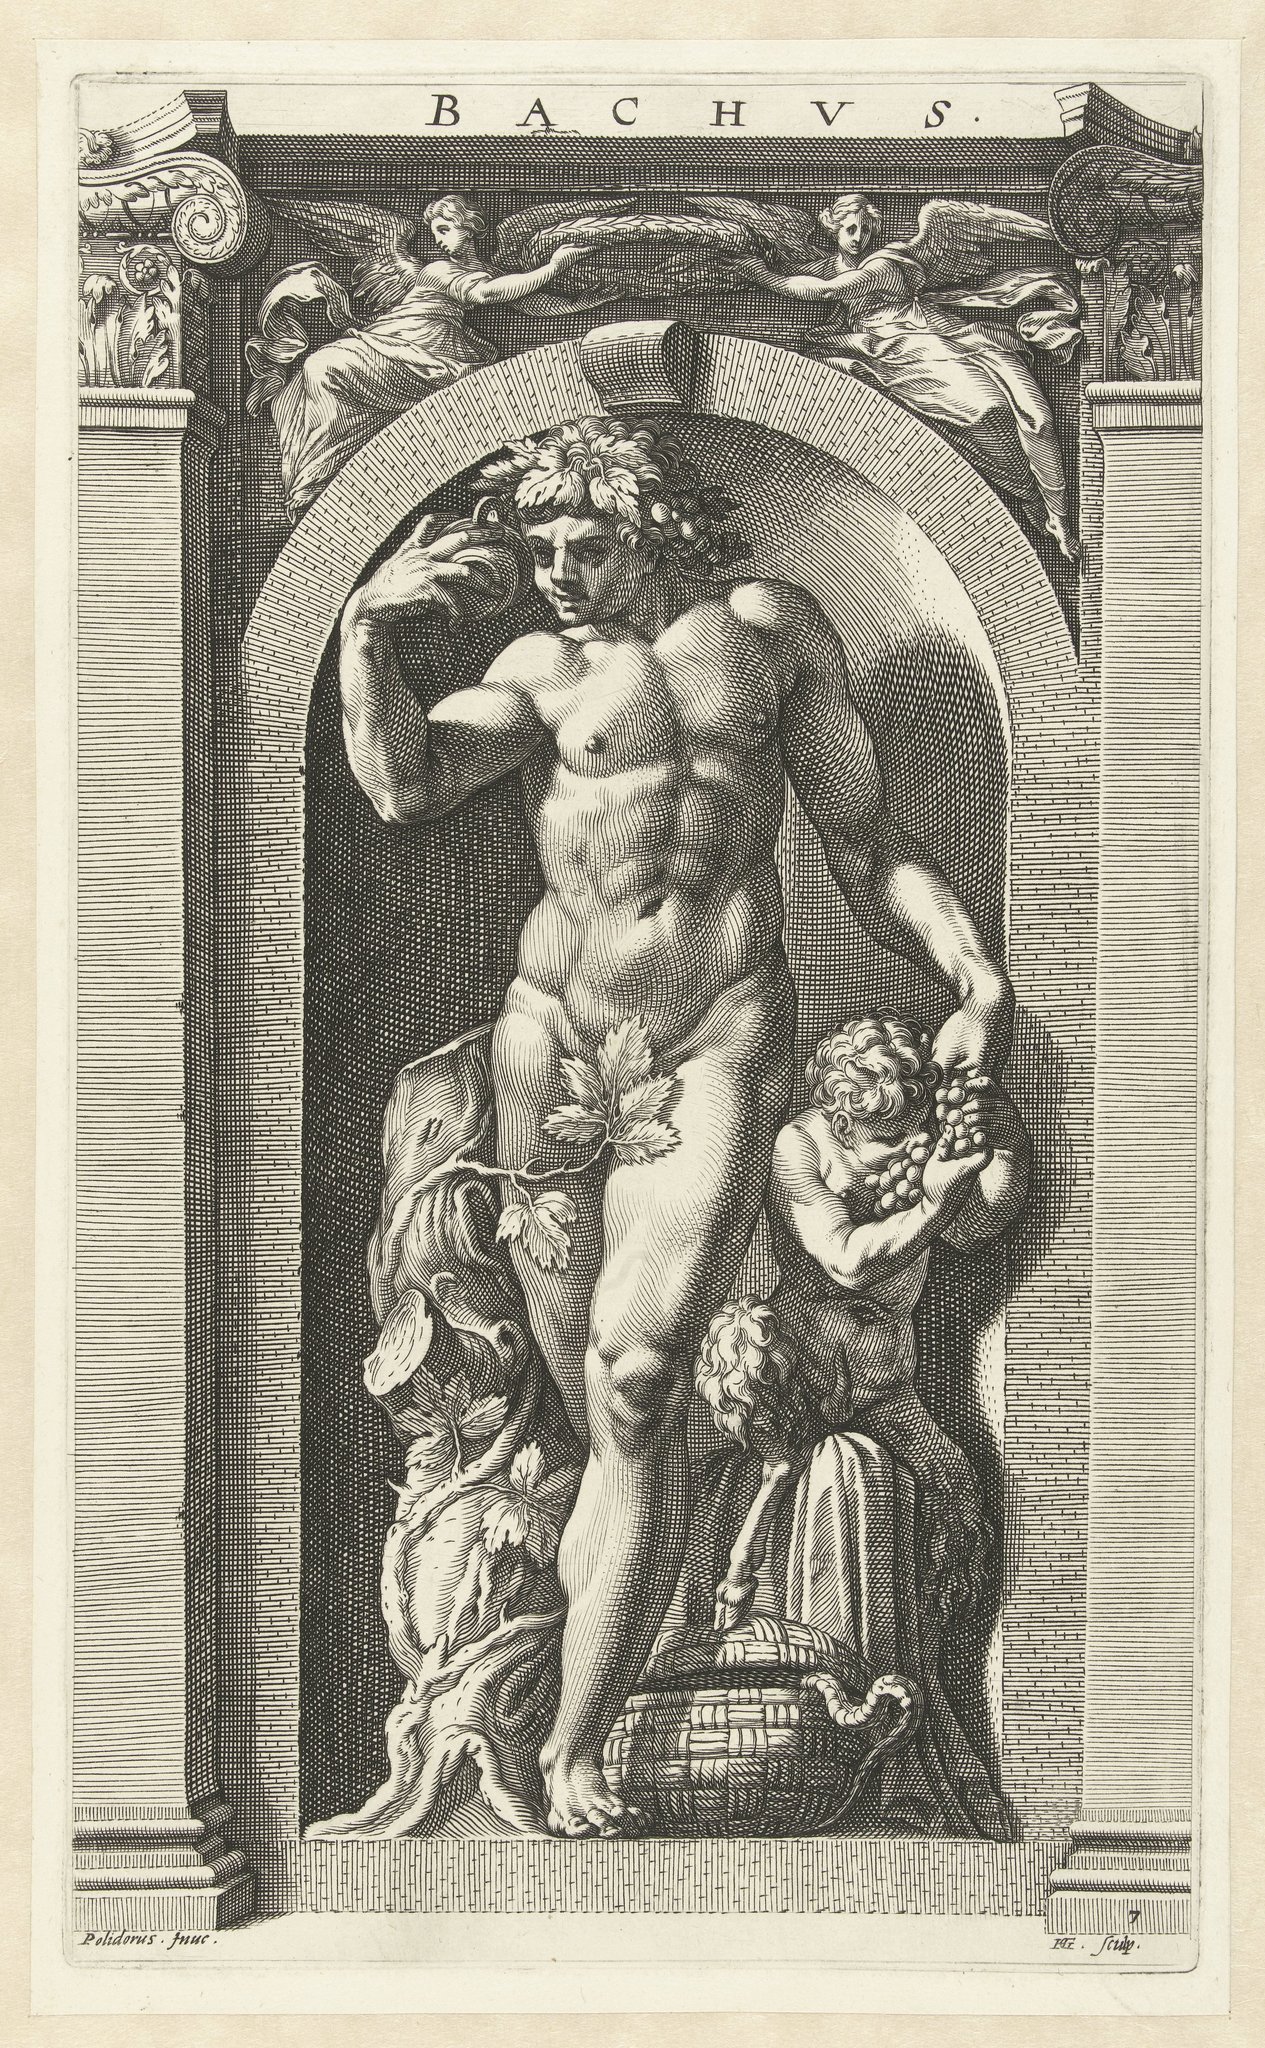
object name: print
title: Bachus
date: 1592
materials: paper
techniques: engraving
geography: haarlem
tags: (story of) bacchus (dionysus), liber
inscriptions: collector's mark: Lugt 240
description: Bacchus, staand in een nis, een drinkbeker in zijn rechterhand, zijn linkerhand bij de schouder van een kleine sater, die druiven eet. Deze prent is onderdeel van een serie van acht prenten van klassieke goden, gebaseerd op schilderingen van Polidoro da Caravaggio op de façade van een Romeins huis, door Goltzius in Rome gezien en nagetekend.